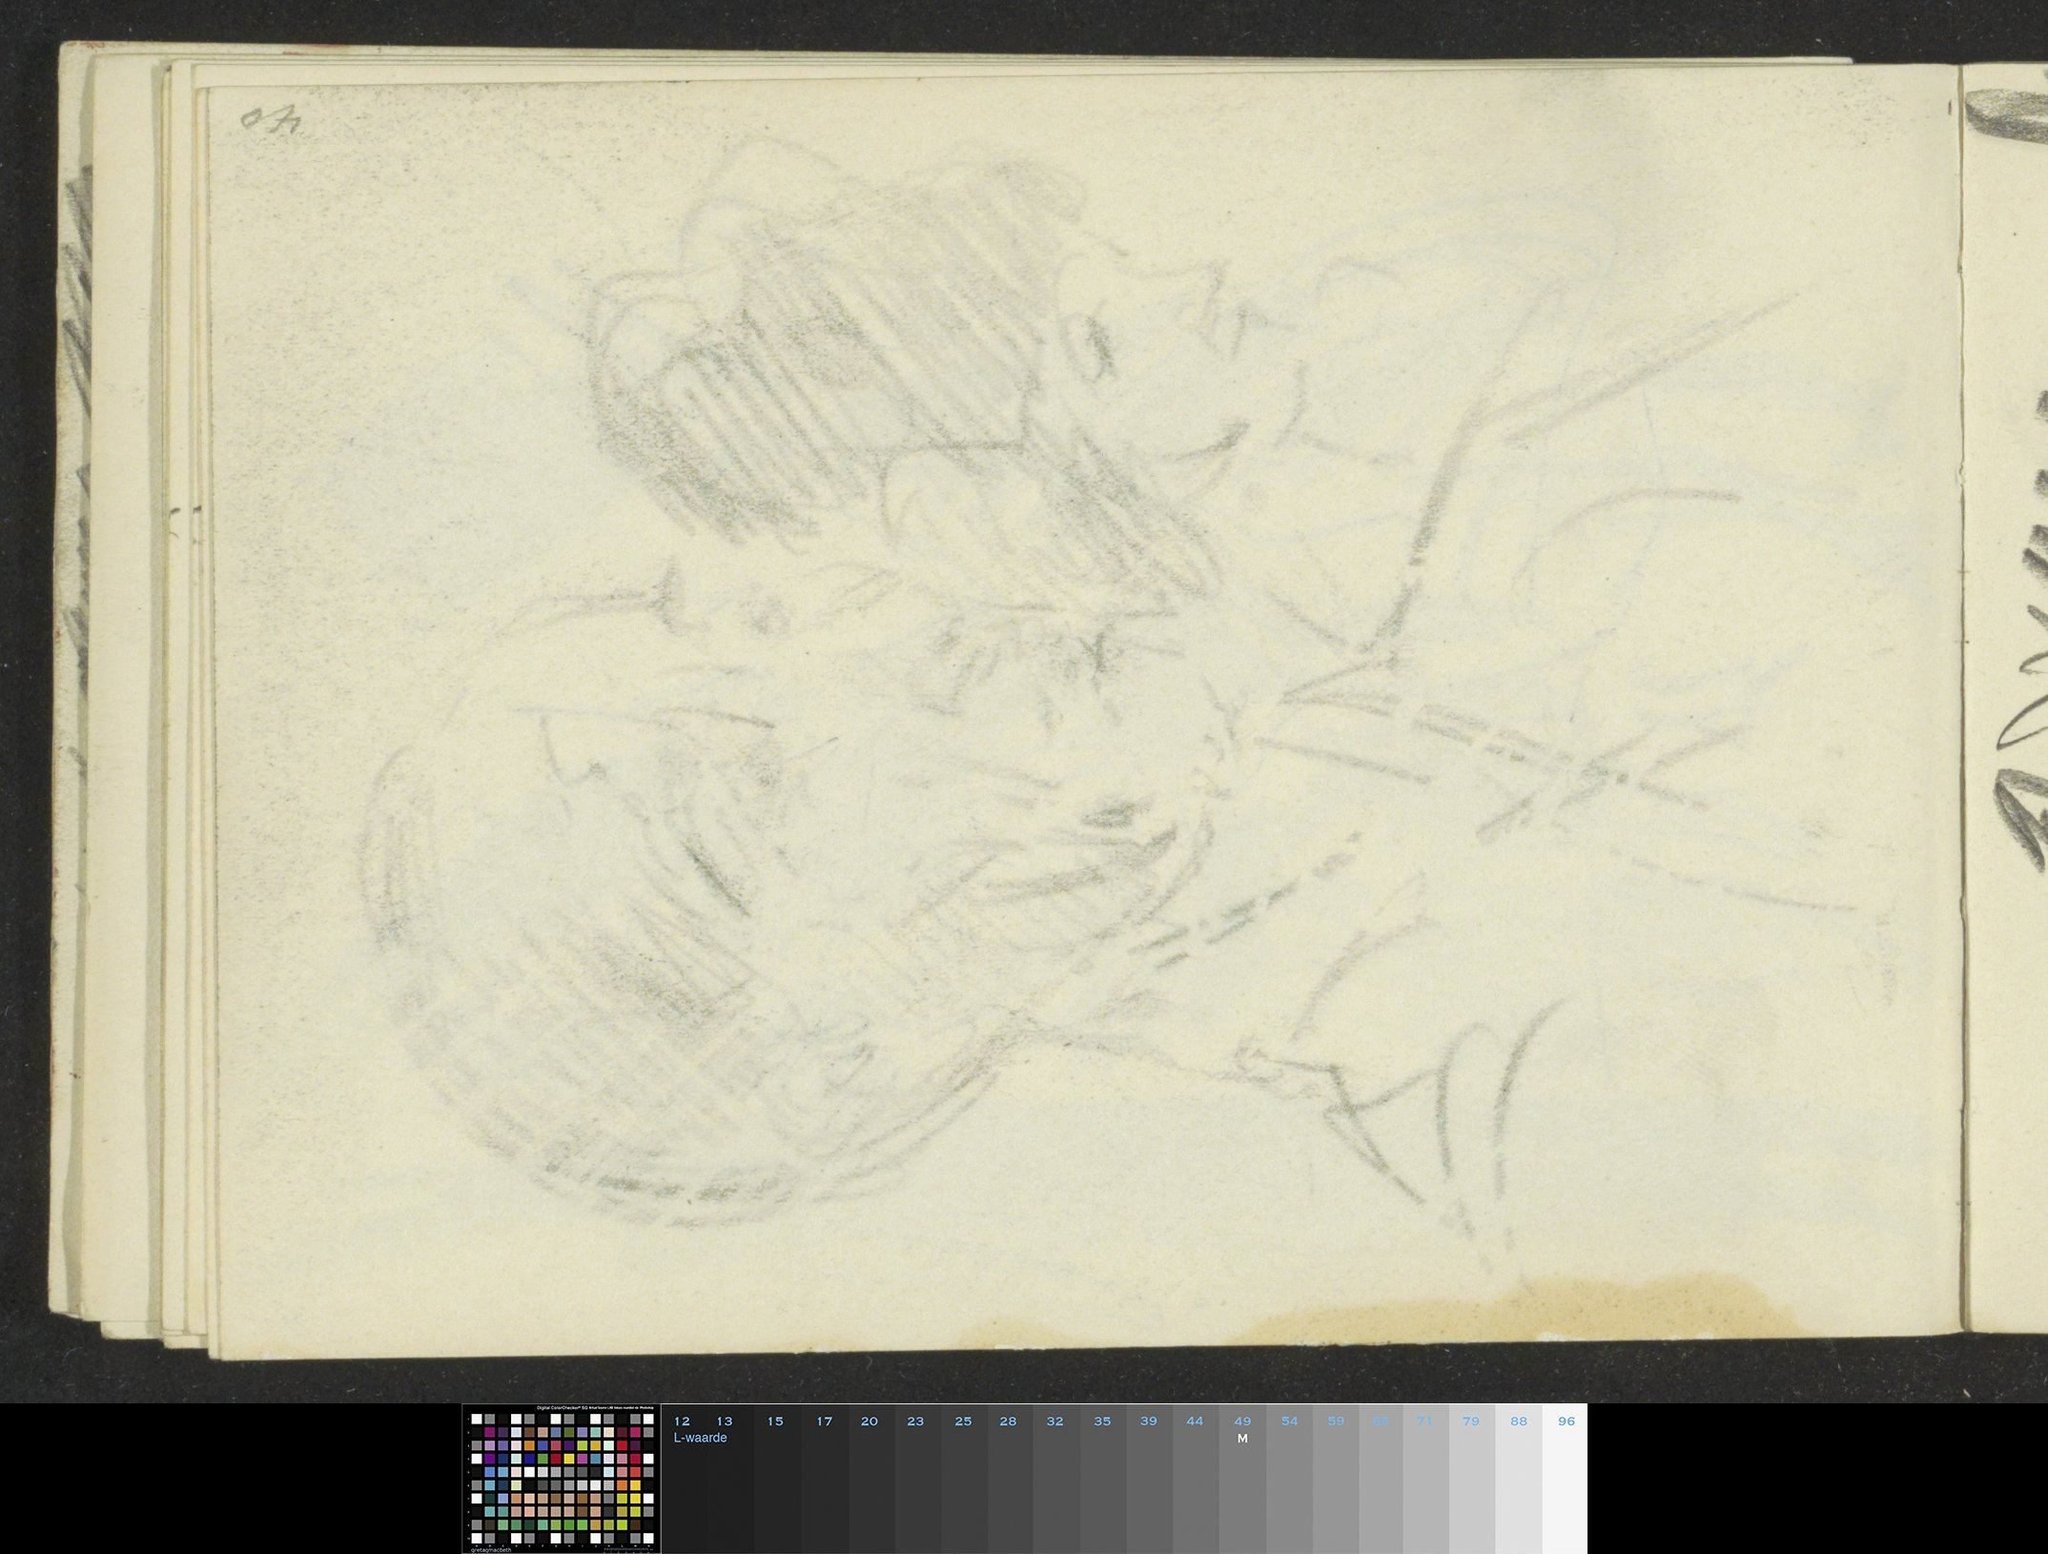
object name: sketchbook leaf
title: Abklatsch van de potloodtekening op blad 13 verso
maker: isaac israels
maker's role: draughtsman, painter, print maker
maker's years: 1865-1934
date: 1875-1934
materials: paper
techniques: printmaking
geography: the hague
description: Blad 11 verso uit schetsboek LXV met 27 bladen.